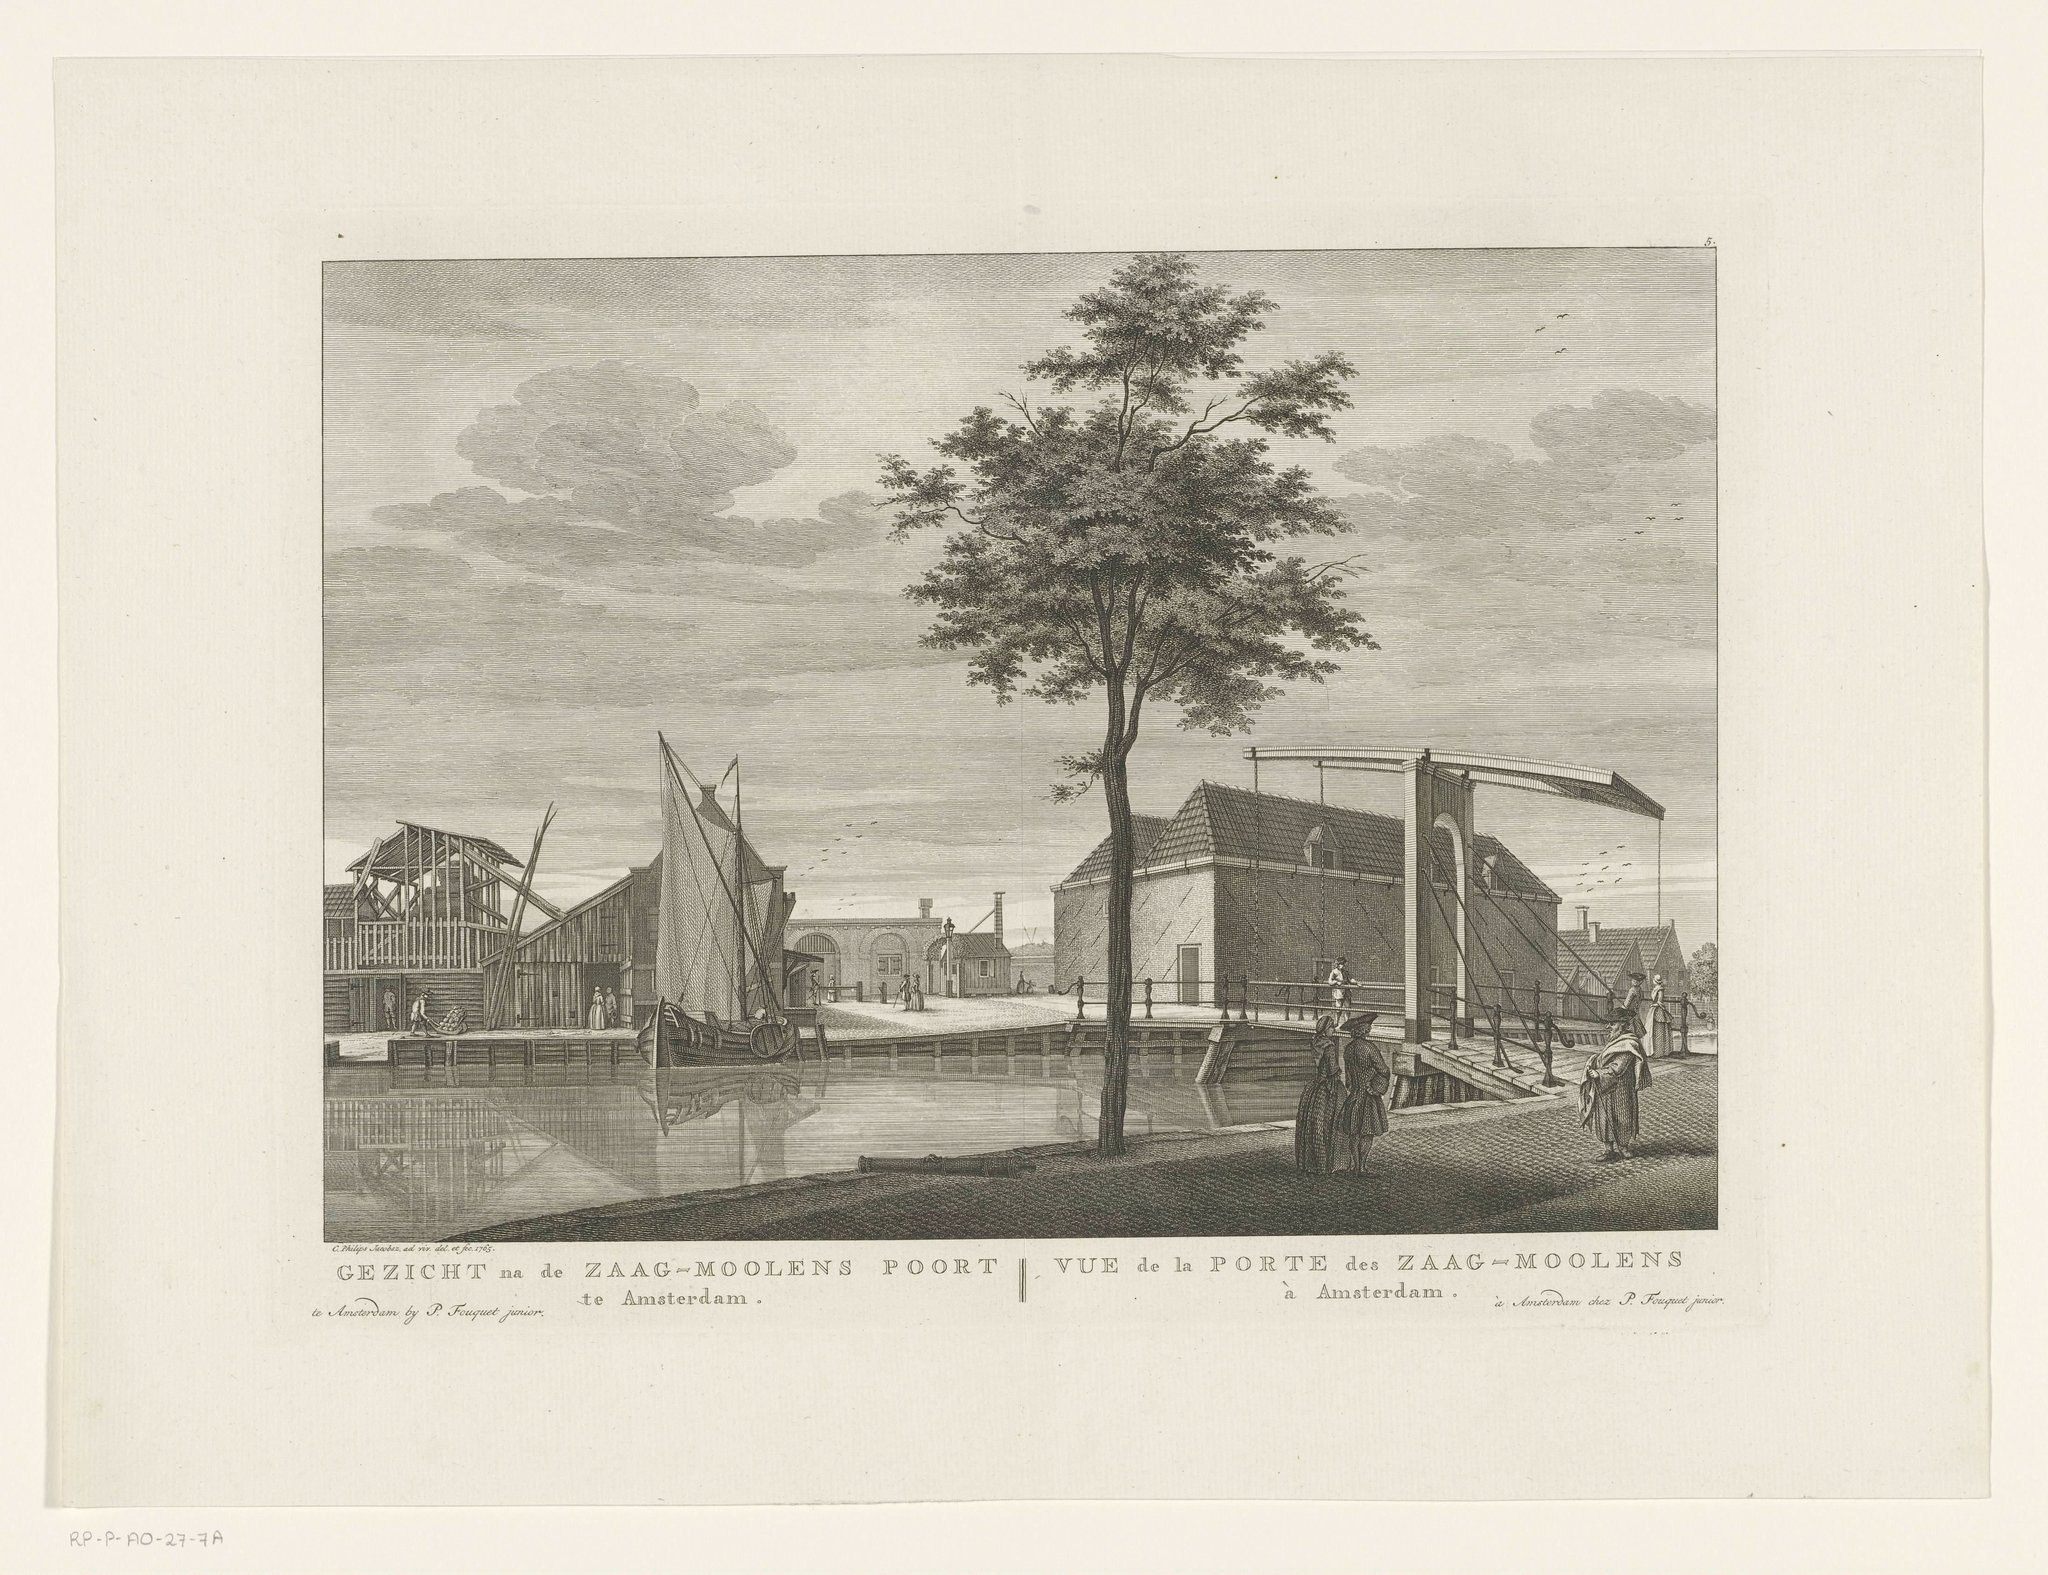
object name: print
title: Gezicht na de Zaag-Moolens Poort te Amsterdam / Vue de la Porte des Zaag-Moolens à Amsterdam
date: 1765-1783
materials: paper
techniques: engraving, etching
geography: amsterdam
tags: bridge in city across river, canal, etc. (+ city(-scape) with figures, staffage), city-gate, canals, waters (in city) (+ city(-scape) with figures, staffage), street (+ city(-scape) with figures, staffage)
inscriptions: collector's mark: Lugt 2228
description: Deze prent is ook gebruikt in de zogenaamde Atlas van Fouquet.* Pierre Fouquet gaf vanaf 1760 stadsgezichten van Amsterdam - naar tekeningen van verschillende kunstenaars, gemaakt door verschillende prentmakers - uit. Deze prenten werden aanvankelijk los of in series verkocht. Zoals toen gebruikelijk kon de koper de prenten zelf laten inbinden. Hiertoe gaf Fouquet tussen 1778 en 1783 een titelblad, plattegrond en inhoudsopgave van de tot dusver 100 uitgegeven prenten uit (1). Gezien de inhoud afhankelijk was van wat de koper had verzameld verschilt de inhoud van de verschillende bewaarde Fouquetatlassen onder deze titel sterk. Ook zijn er exemplaren bekend waar tevens andere prenten aan zijn toegevoegd. Omdat er behoefte bleek aan uitleg bij de platen werd in 1783 een nieuwe versie van de atlas uitgegeven, aangevuld met tekst en twee prenten. De aangegeven volgorde veranderde maar de platen van de al eerder uitgegeven prenten bleven ongewijzigd. Deze uitgave werd in opdracht van Fouquet gedrukt bij Daniël Jean Changuion en Petrus den Hengst (2). Een tiental platen werd bijgewerkt en verscheen, met nieuw impressum, in het vervolg van Wagenaars geschiedenis van Amsterdam, uitgeven door Petrus Conradi en Folkert van der Plaats (3). Een aantal jaar na het overlijden van Fouquet kwam Evert Maaskamp met een nieuwe uitgave van de atlas, met verbeterde tekst en toevoeging van twee prenten. Op alle platen verwijderde hij het oude en liet hij zijn eigen impressum zetten (4). De huidige staat van de prent komt voor in exemplaren van de onder (1) en (2) genoemde werken. * Onder de Atlas van Fouquet of Fouquetatlas verstaan we de hieronder vermelde publicaties (1), (2) en (4). (1). Afbeeldingen van de wyd-vermaarde koopstad Amsterdam benevens des zelvs voornaamste gebouwen en gezigten alle naar het leeven getekend / Receuil des edifices les plus considerables et des plus belles vues, de la fameuse ville d'Amsterdam, dessinées d'après nature. Amsterdam: Pierre Fouquet, 1778-1783. (2). Nieuwe atlas, van de voornaamste gebouwen en gezigten der stad Amsterdam, met derzelver beknopte beschryvingen. 2 delen. Amsterdam: Daniël Jean Changuion en Petrus den Hengst [in opdracht van Pierre Fouquet], 1783. (3). Stijl, Simon. Amsterdam, in zyne geschiedenissen, voorregten, koophandel, gebouwen, kerkenstaat, schoolen, schutterye, gilden en regeeringe, beschreeven. Om te dienen ten vervolge op het werk van Jan Wagenaar (…). 10 delen. Amsterdam en Harlingen: Petrus Conradi en Folkert van der Plaats, 1788-1801. (4). Nieuwe atlas, van de voornaamste gebouwen en gezigten der stad Amsterdam. Met derzelver beknopte beschryvingen. Amsterdam: Evert Maaskamp, 1805. * Het aantal vermelde staten is gebaseerd op het aantal gevonden staten. Mogelijk zijn er meer staten van deze prent. Zie RP-P-OB-60.126 voor eerste bekende staat.